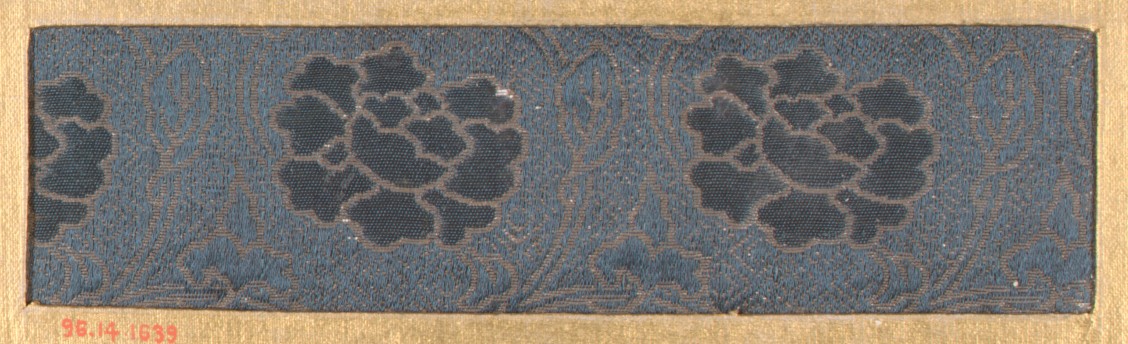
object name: piece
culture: japanese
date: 1701-1900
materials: silk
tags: flowers